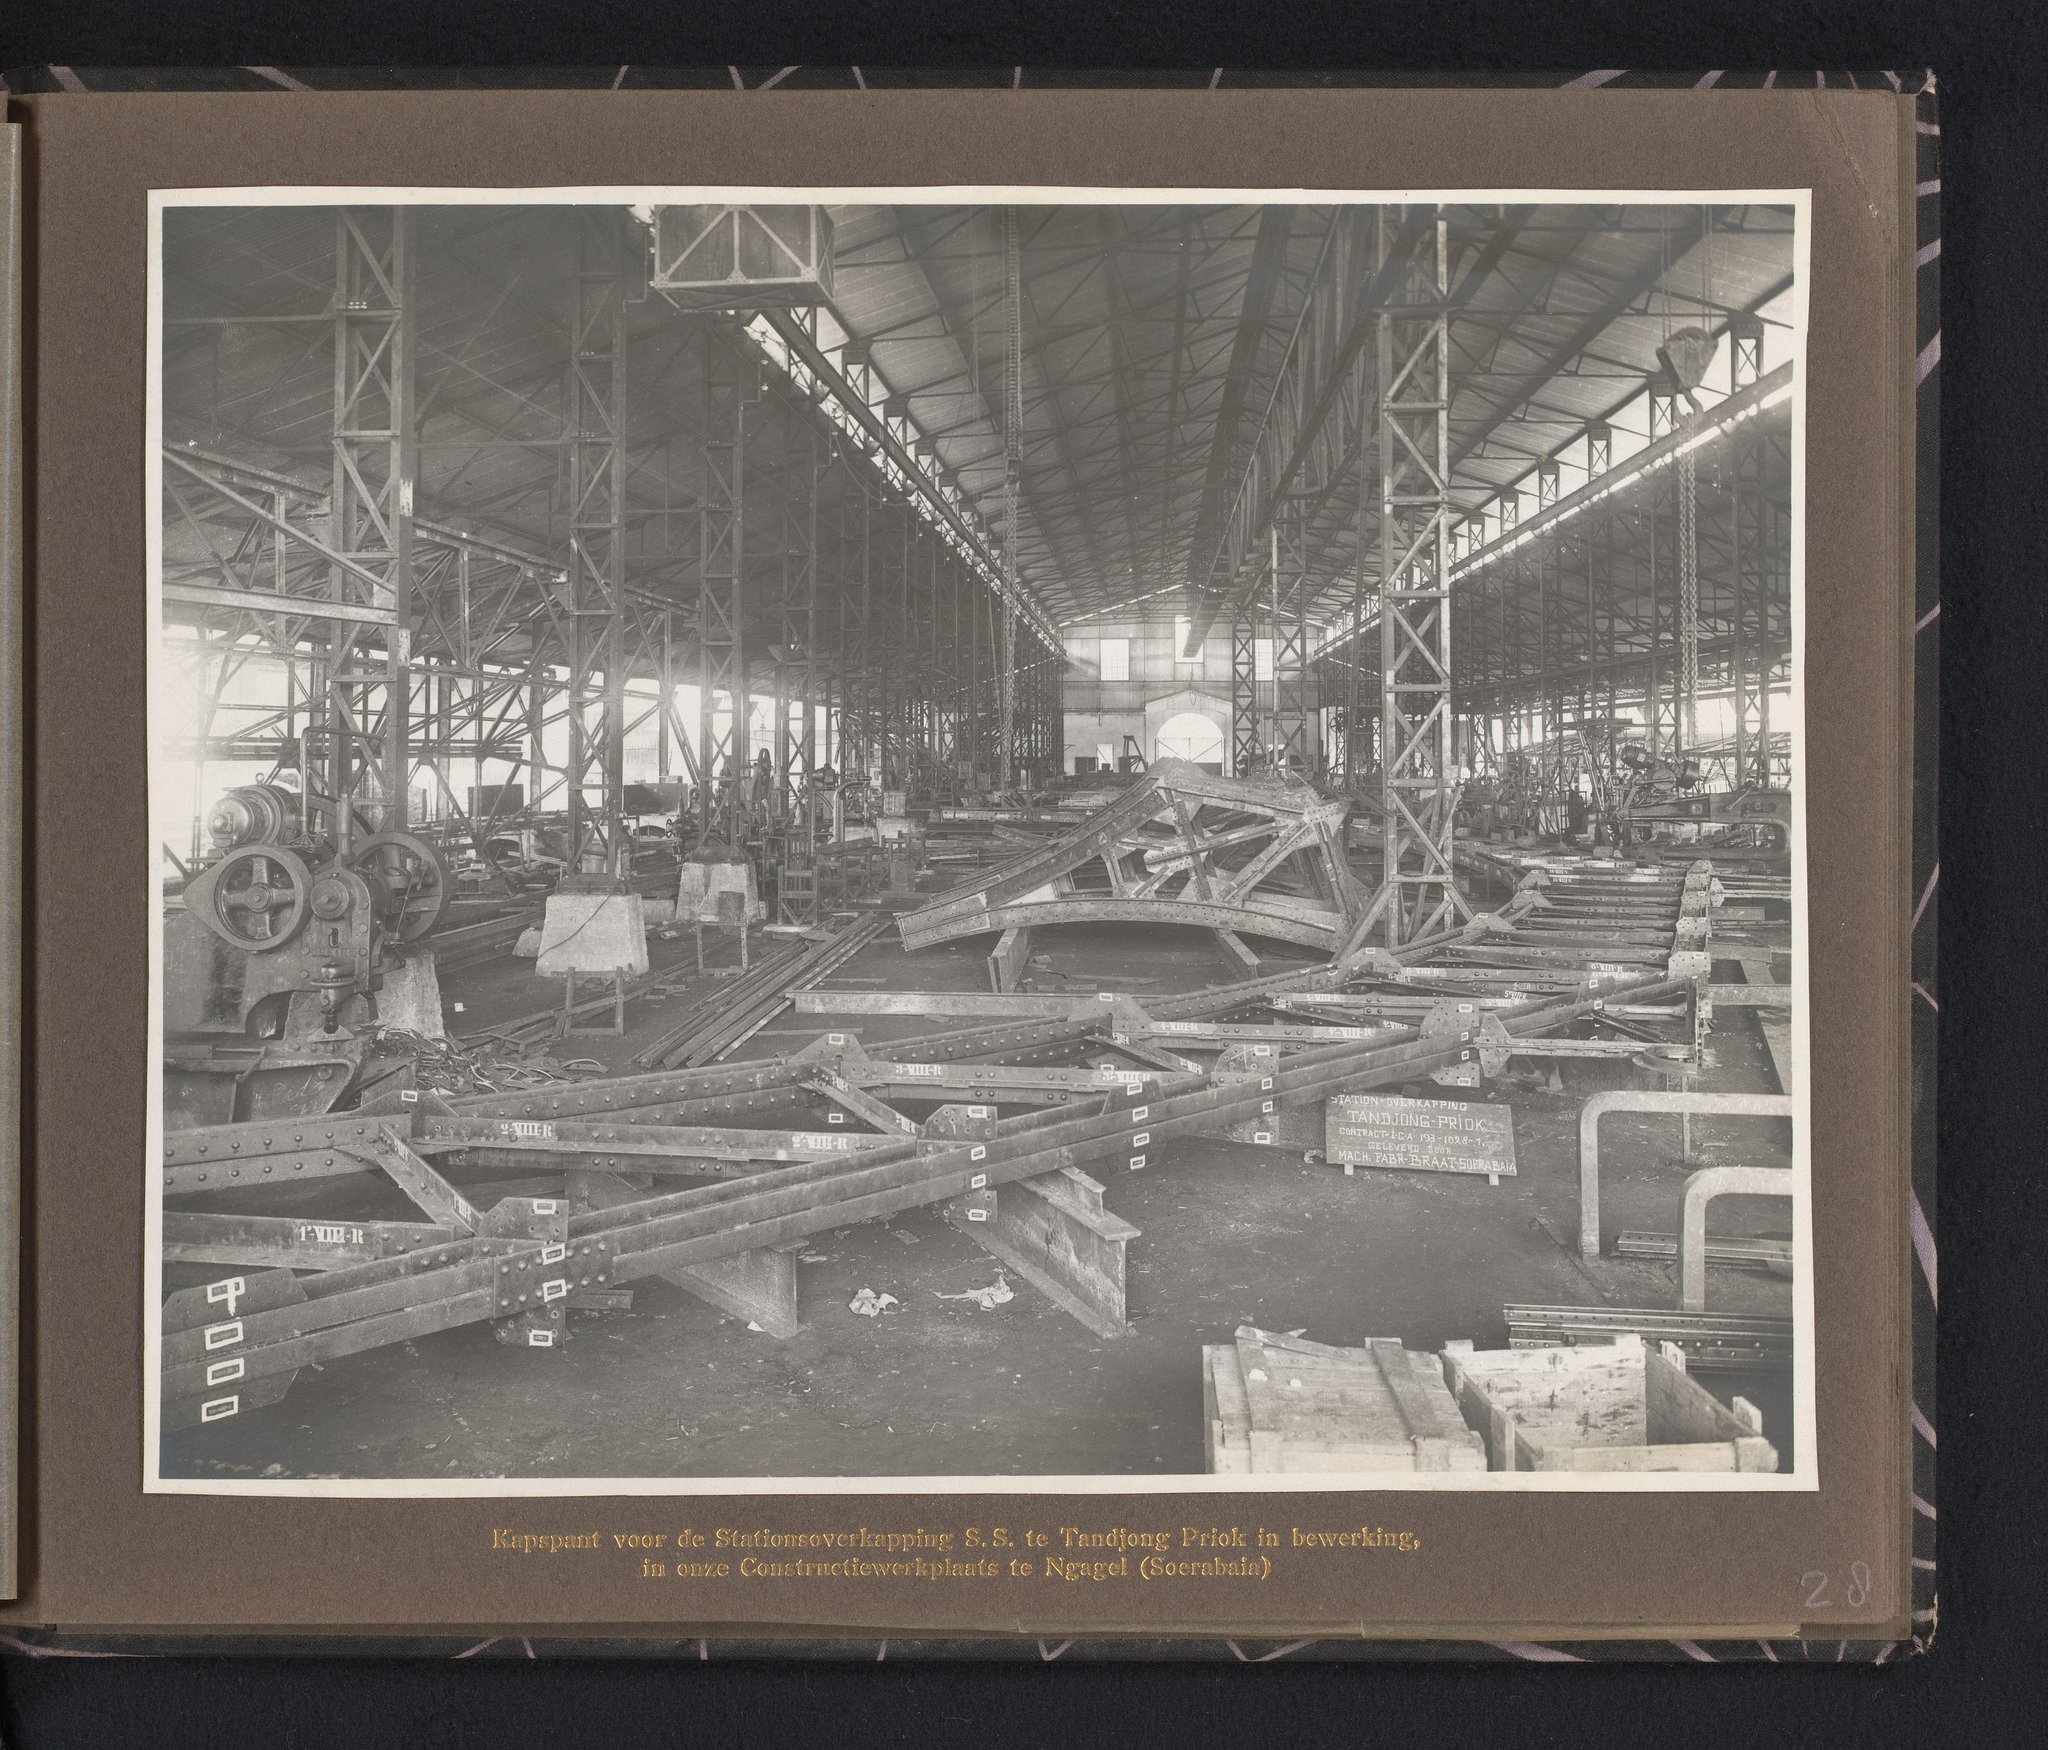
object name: photograph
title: Kapspant voor de Stationsoverkapping S.S. te Tandjong Priok in bewerking, in onze Constructiewerkplaats te Ngagel (Soerabaia)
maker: Anonymous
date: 1916-1924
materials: cardboard, photographic support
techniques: gelatin silver print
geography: surabaya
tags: colonial system, station; shelter (railway, tramway), java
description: Albumblad met een foto van een kapspant voor een stationsoverkapping voor het treinstation te Tandjong Priok, tijdens de constructie in de werkplaats te Soerabaja. Onderdeel van het fotoalbum Machinefabriek Braat Soerabaia-Djocja-Tegal, ca. 1916-1924.